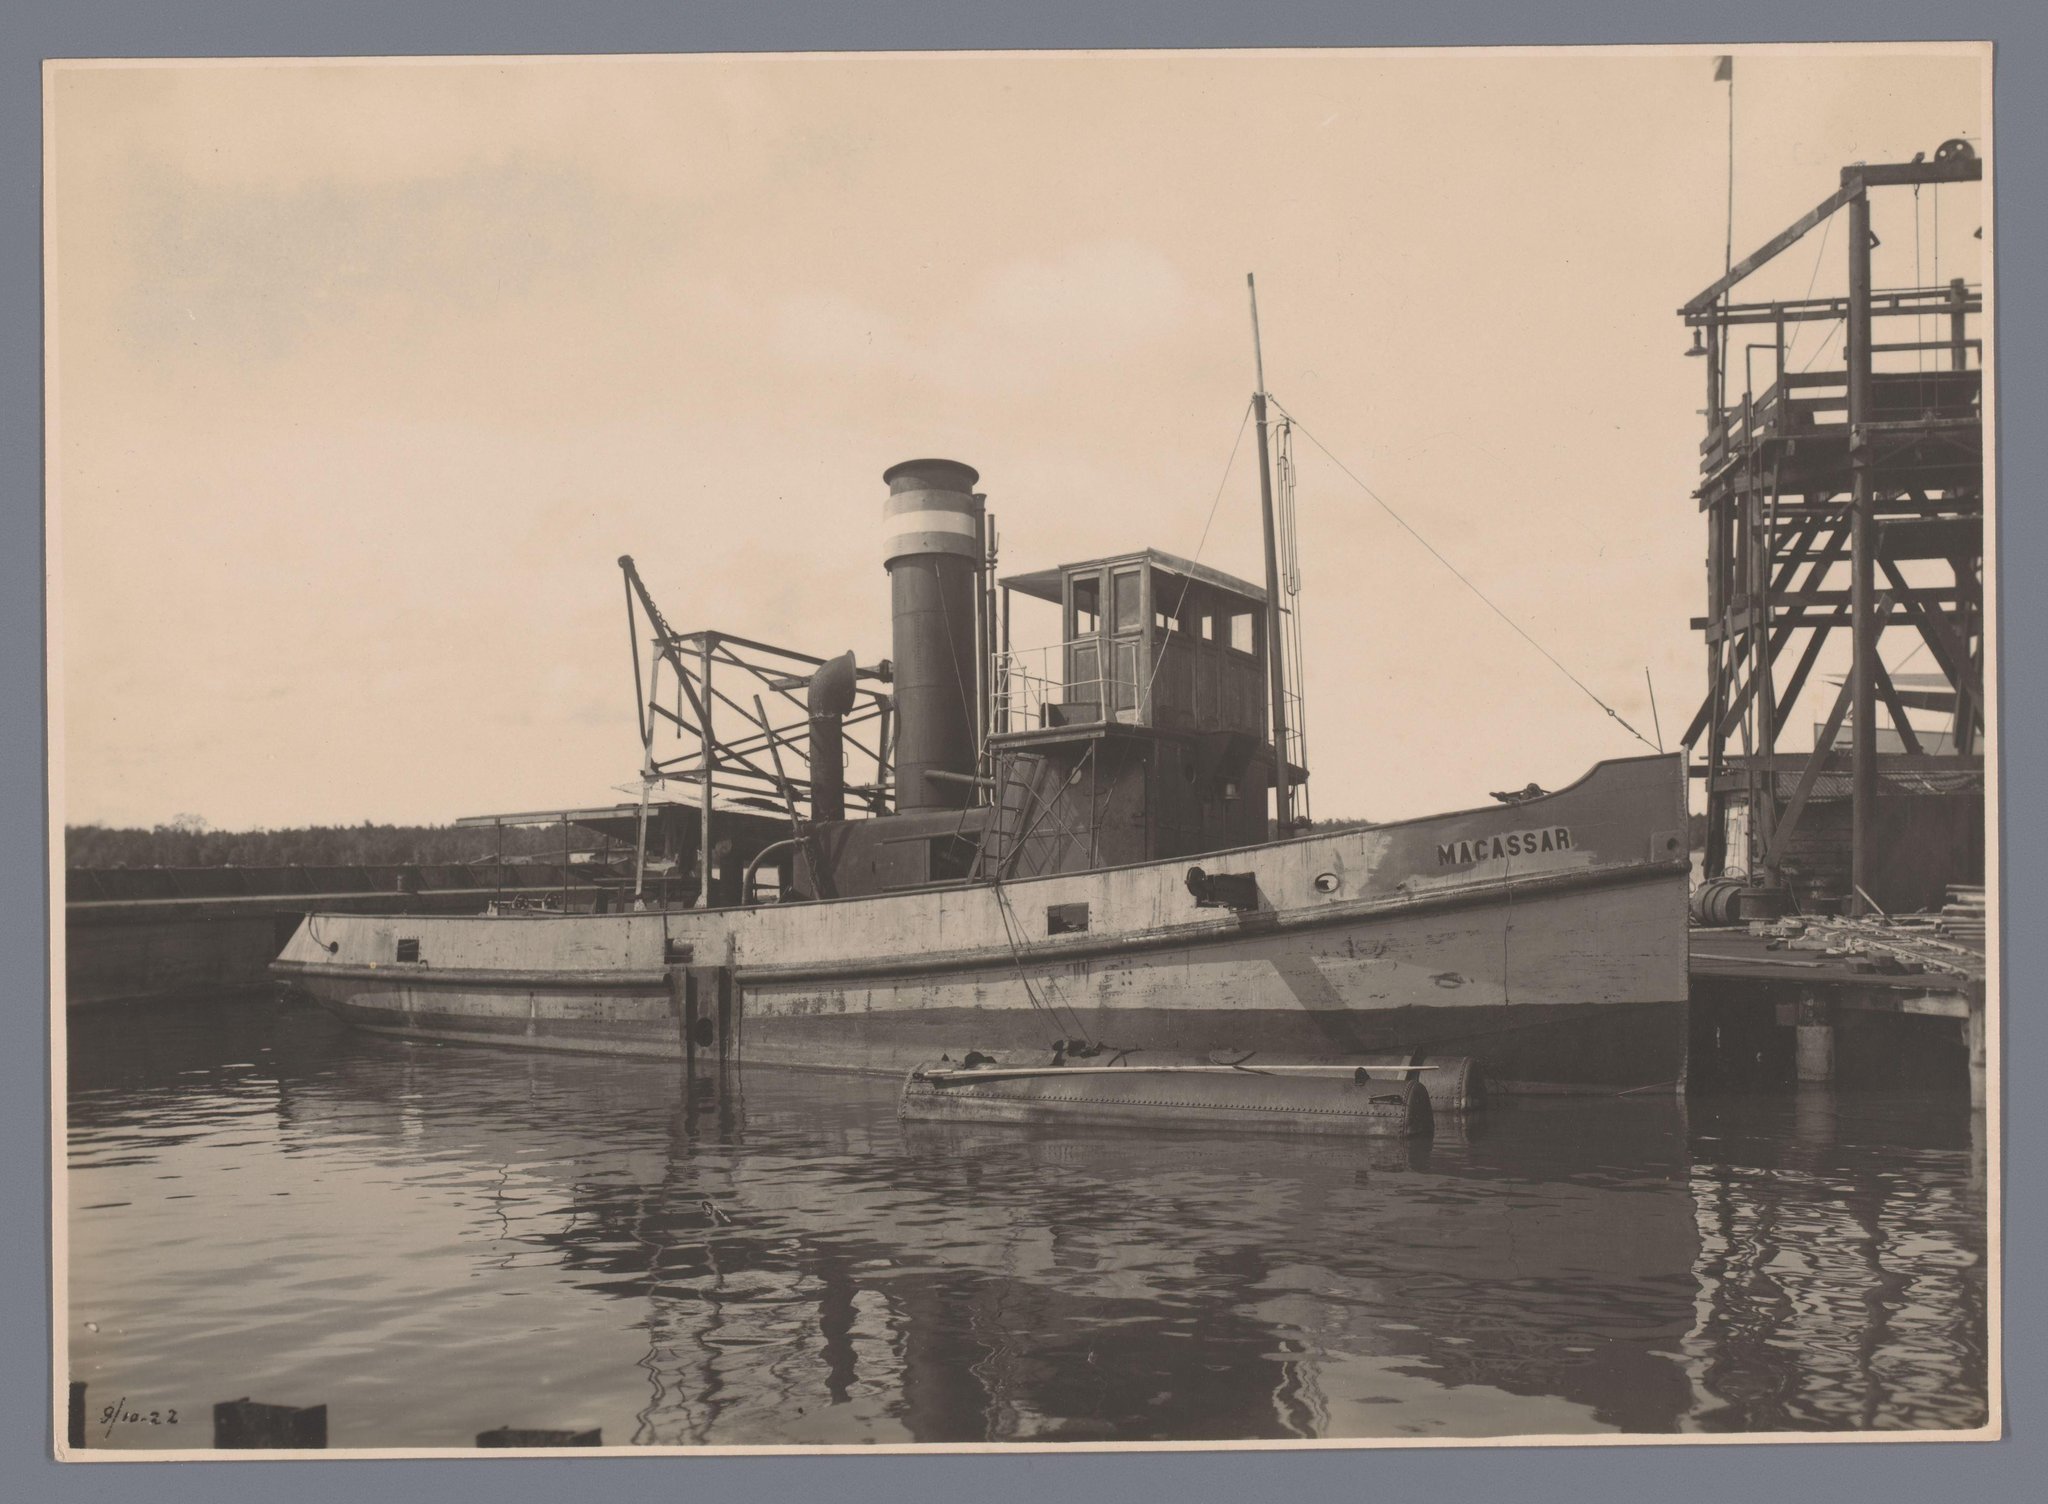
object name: photograph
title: Zuiger Makasser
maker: Anonymous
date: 1922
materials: photographic support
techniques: gelatin silver print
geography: belawan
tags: building-site, steamship, motorship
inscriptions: date: ‘9/10-22’, inscription: ‘No. 241 Zuiger Makasser’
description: De zuiger 'Macassar', liggend aan de kade. Genummerd: 241. Onderdeel van de groep van losse foto's over de aanleg van de haven Belawan aan de kust voor Medan, Sumatra 1921-1922.